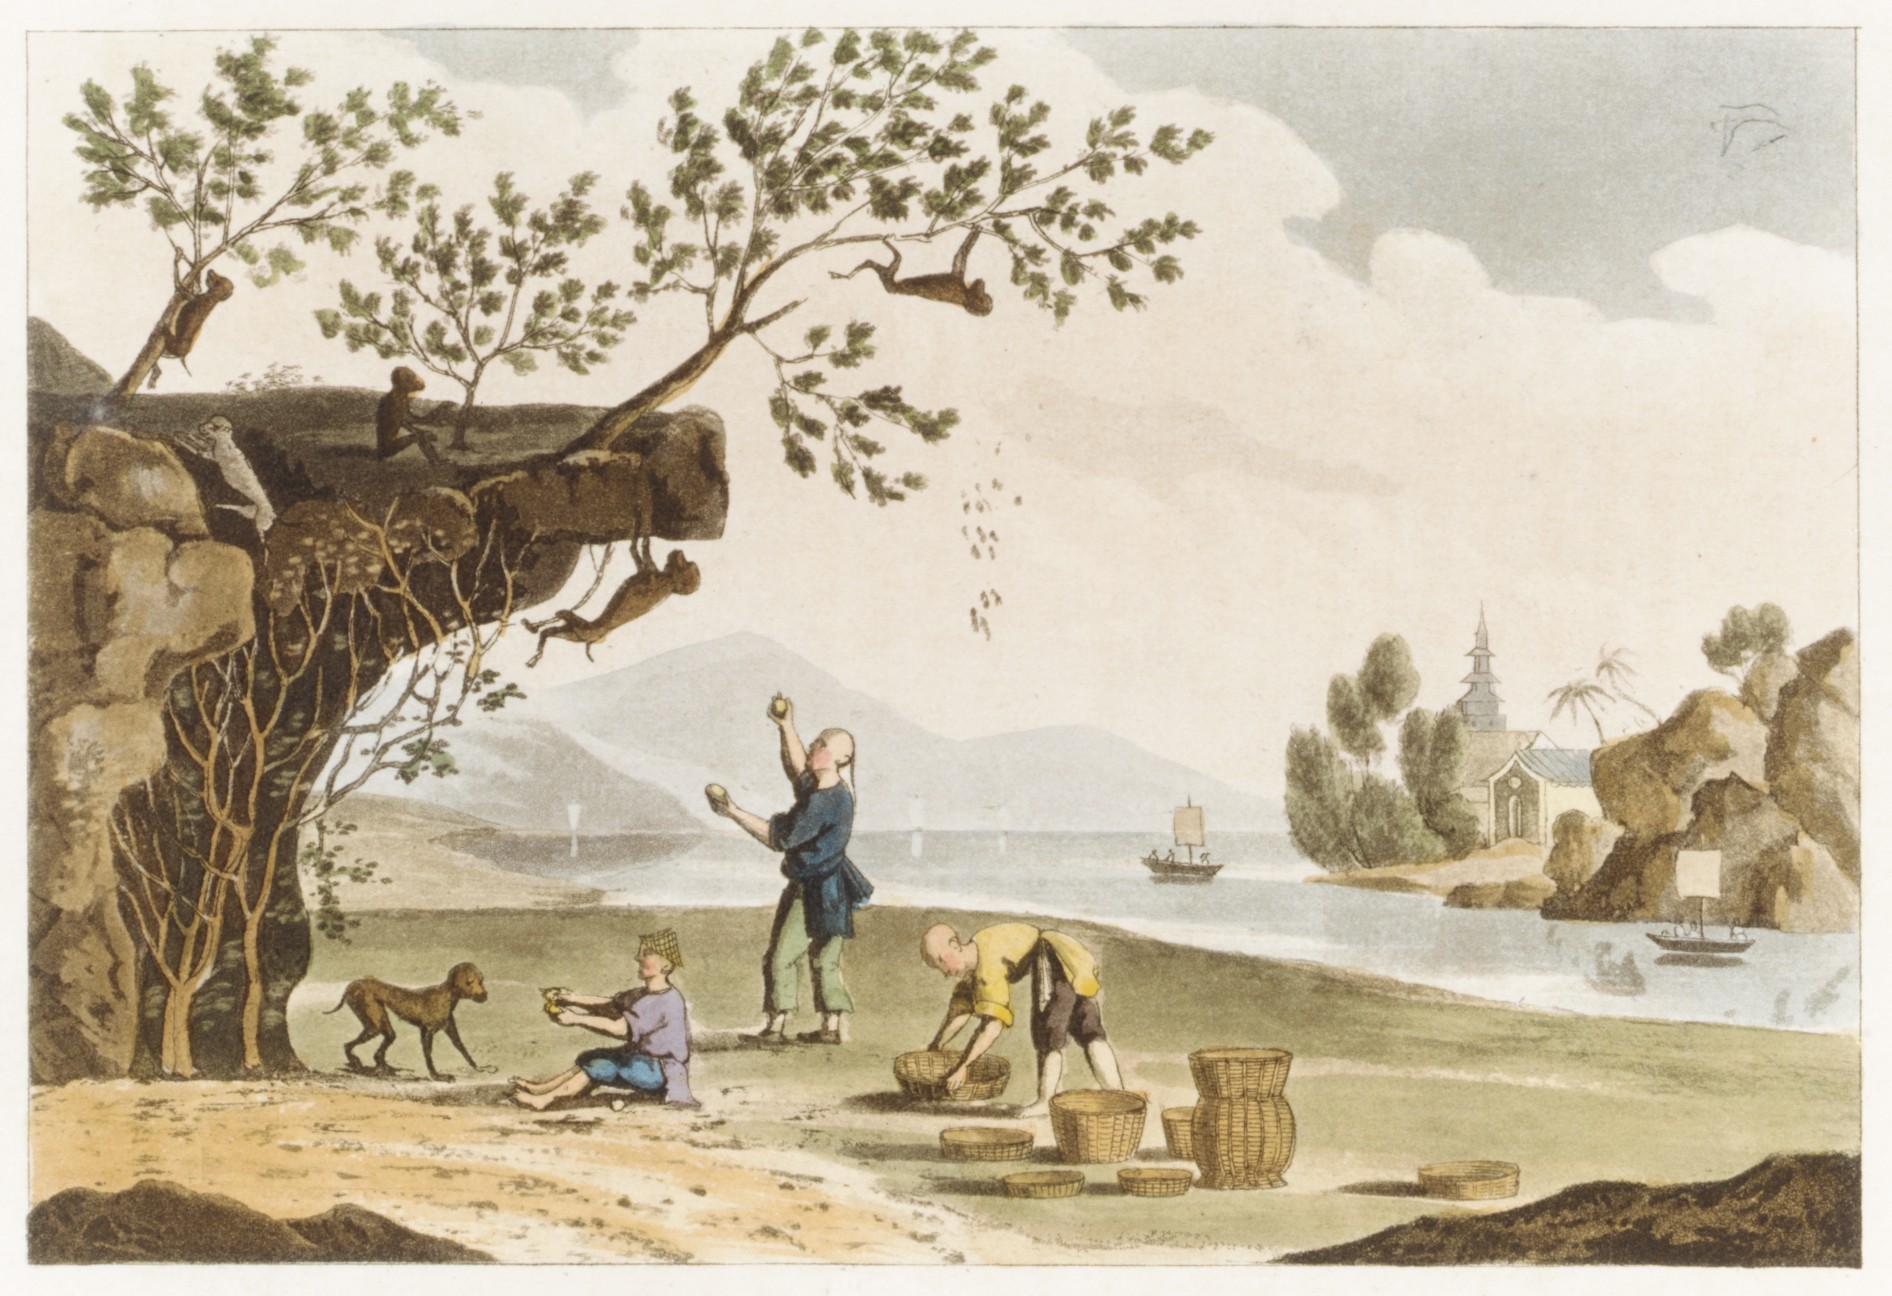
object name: book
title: The Repository of Arts, Literature, Fashions, Manufactuers, &c., 2nd series, volume 12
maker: rudolph ackermann, london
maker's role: publisher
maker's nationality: british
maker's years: 1794-1832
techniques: aquatint, engraving, etching, hand coloring, lithograph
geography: england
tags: men,monkeys,trees,boats